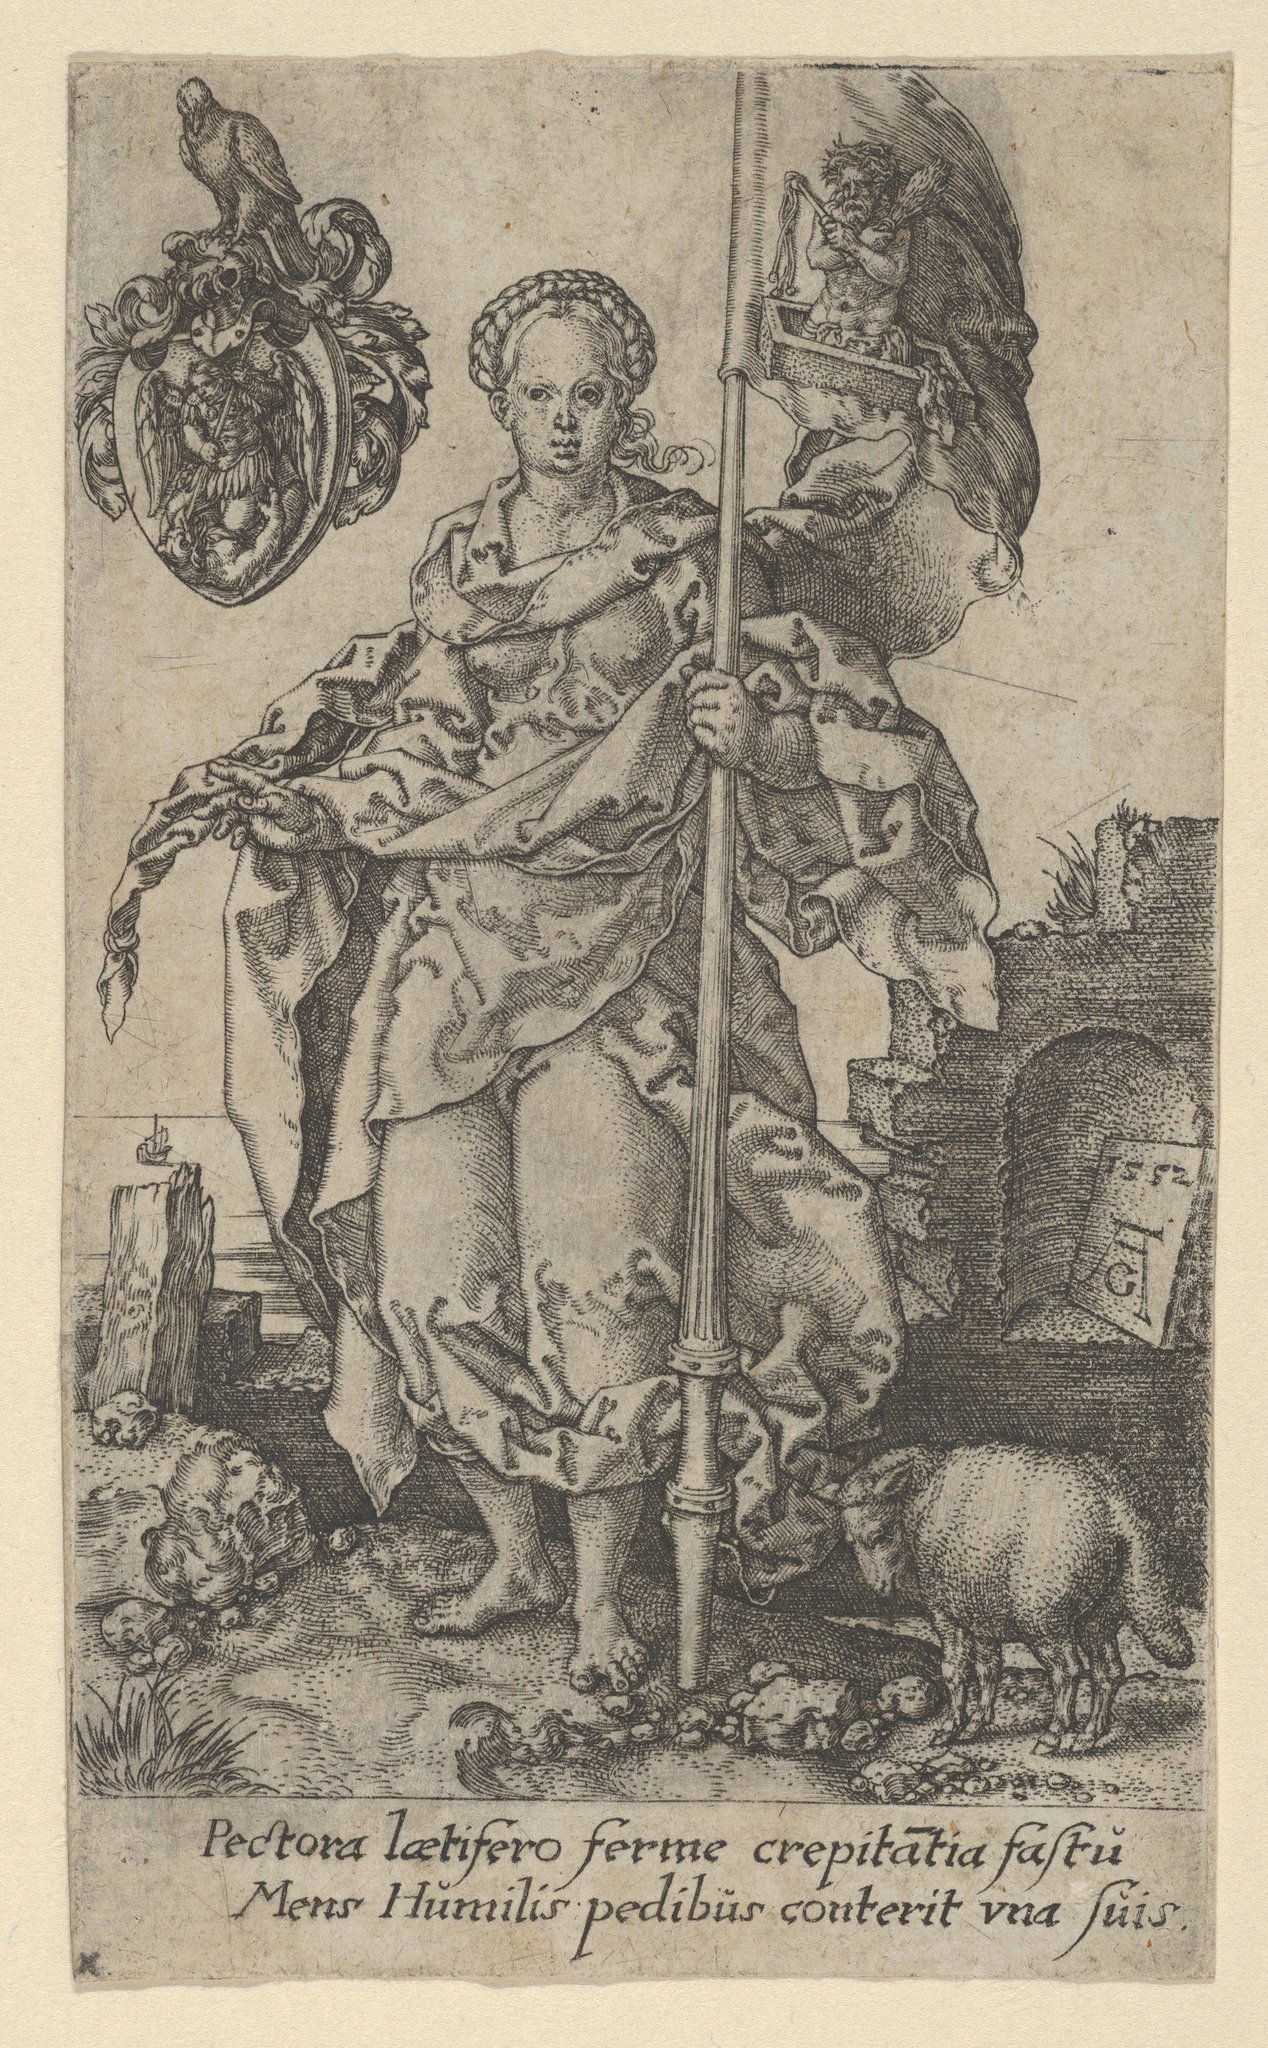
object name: print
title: Modesty, from The Virtues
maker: heinrich aldegrever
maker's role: artist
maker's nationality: german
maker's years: 1502-1561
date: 1552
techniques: engraving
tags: birds,women,rams